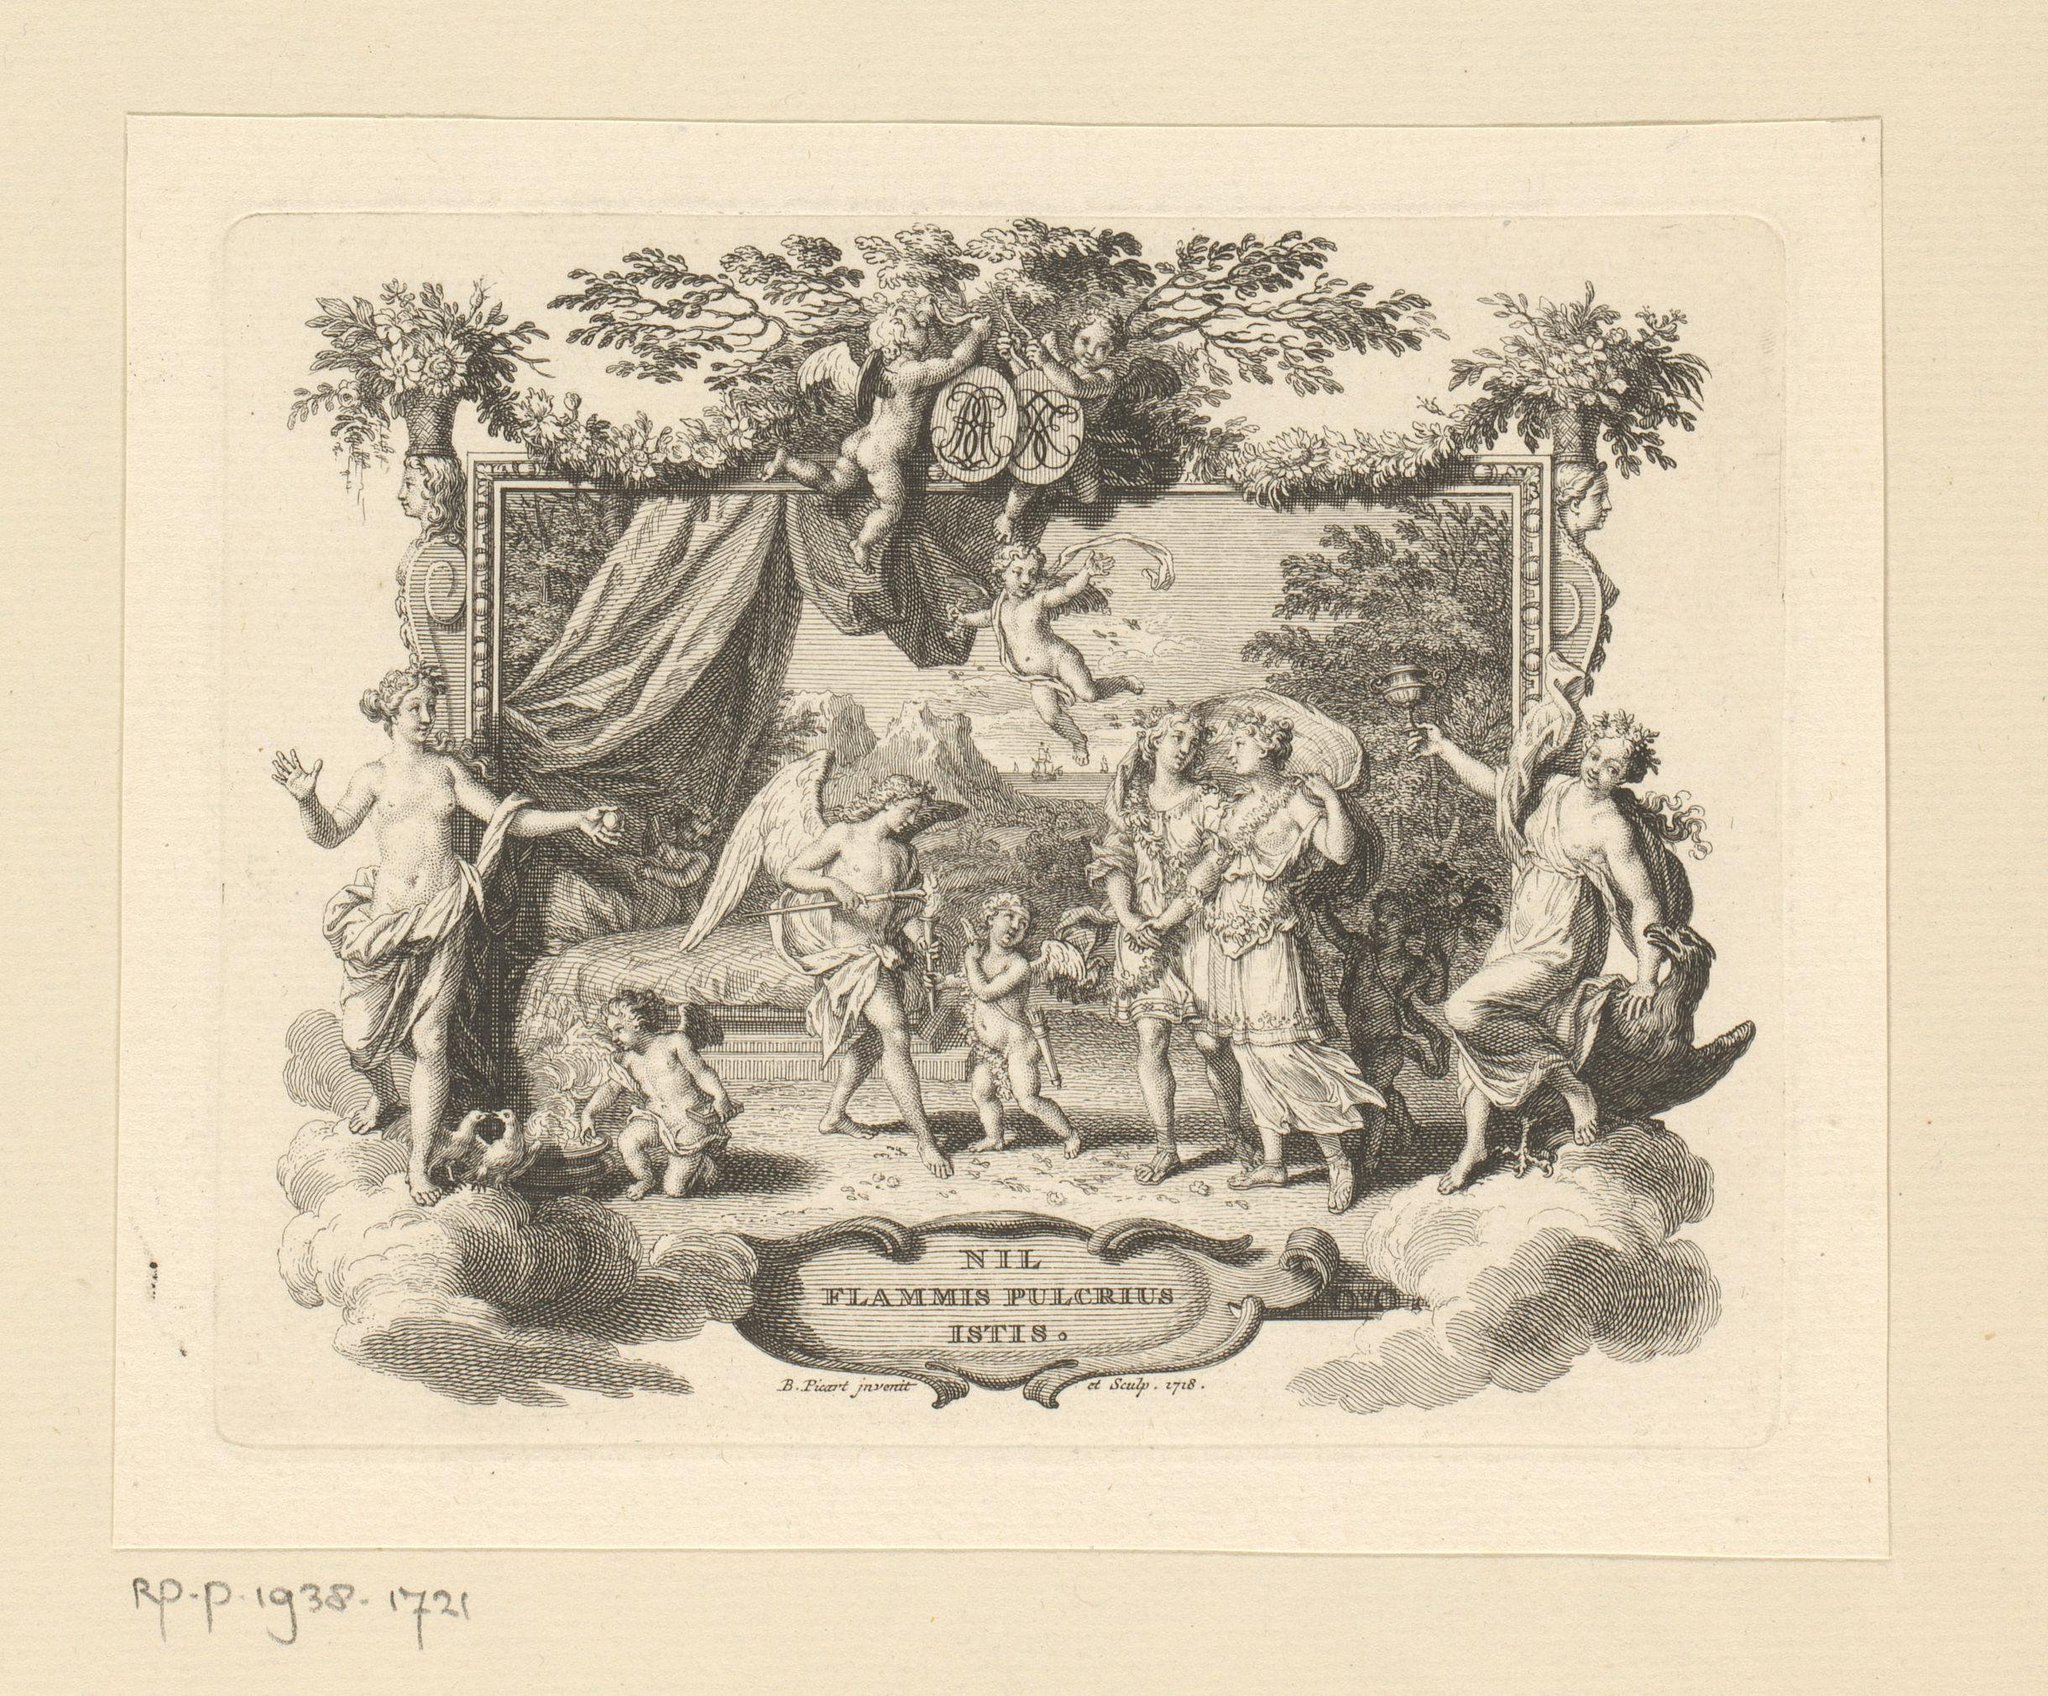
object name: titelblad, titelpagina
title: Titelvignet voor: Gezangen ter bruilofte van (...) Arent Bosch, en (...) Eletta Thesingh, [1718]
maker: bernard picart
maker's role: draughtsman, print maker, publisher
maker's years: 1673-1733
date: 1718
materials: paper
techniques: engraving, etching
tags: (story of) hymen(aeus), (story of) hebe (juventas), (story of) cupid, amor (eros), (story of) venus (aphrodite), betrothal and marriage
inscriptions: collector's mark: Lugt 2228, collector's mark: Lugt 2760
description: Allegorische voorstelling ter gelegenheid van een huwelijk. Het echtpaar loopt, begeleidt door Amor, naar de huwelijksgod Hymen en het huwelijksbed. Links biedt Venus de bruid een gouden appel aan en rechts biedt Hebe, de godin van de jeugd, haar een vat met nectar aan. De voorstelling is gevat in een ornamentele lijst. De lijst wordt bekroond door twee putti met de initialen van de echtelieden. Midden onder een cartouche met het devies: 'Nil flammis pulcrius istis'.